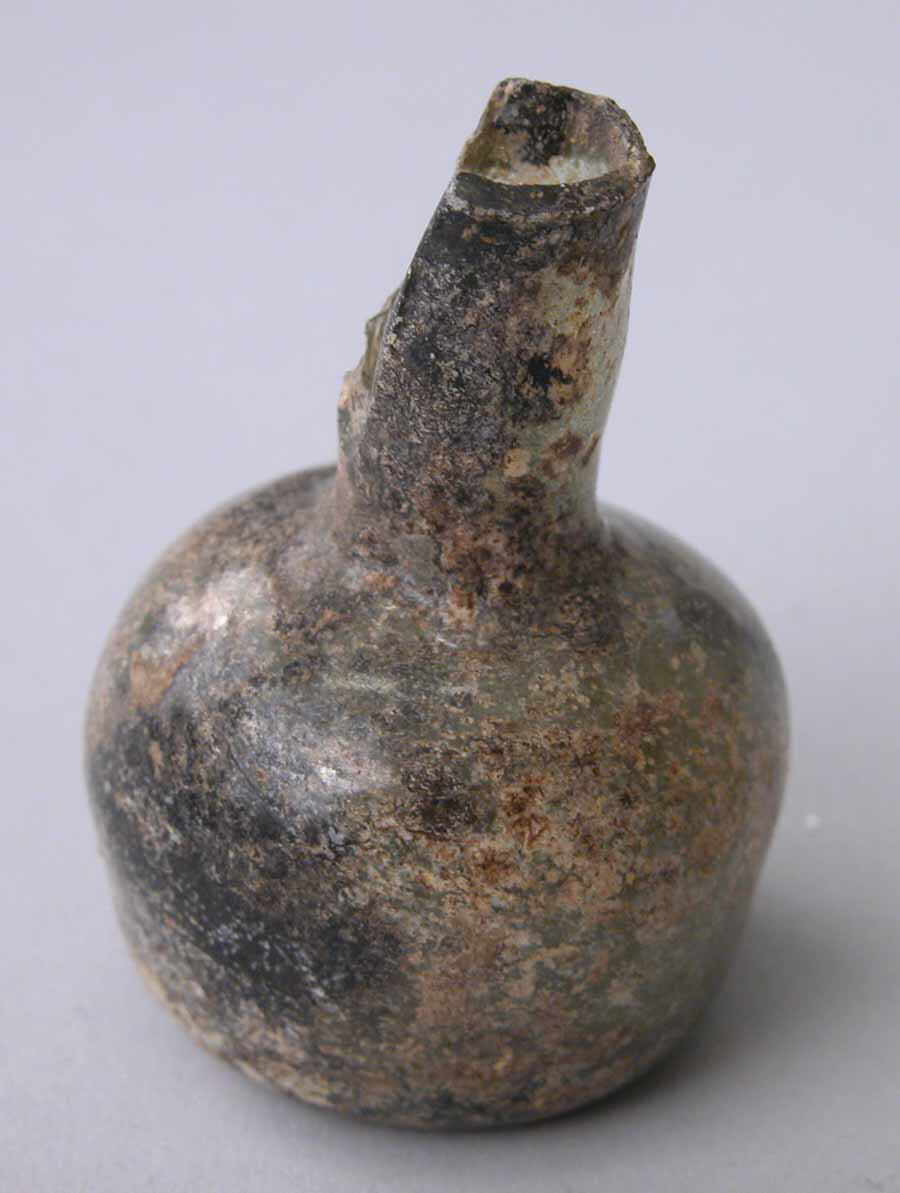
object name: bottle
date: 601-800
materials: glass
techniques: glassblowing, tooling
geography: iraq